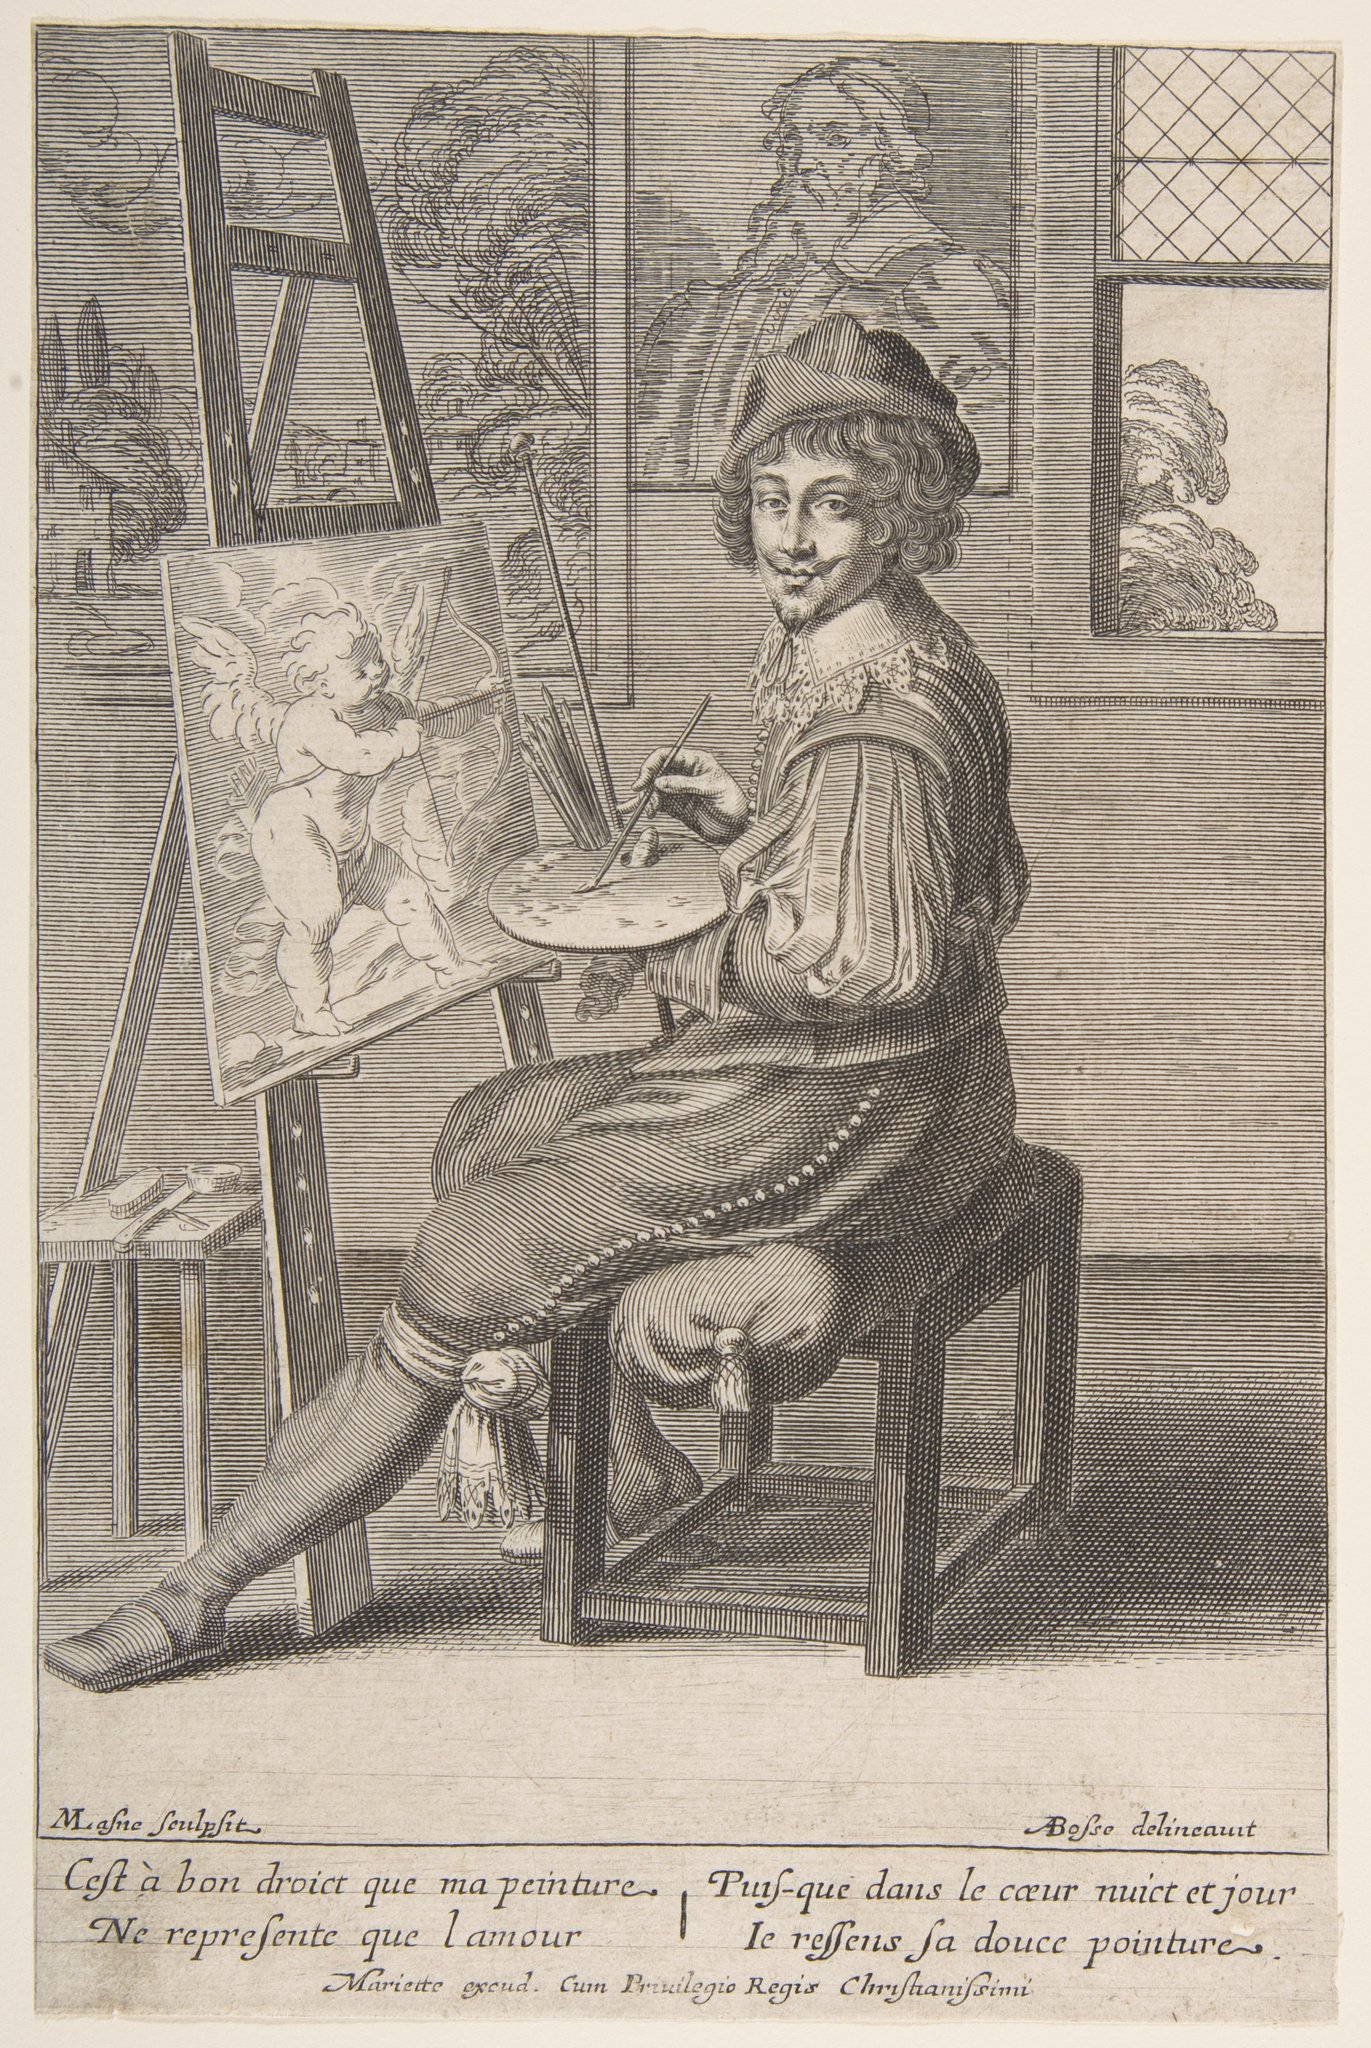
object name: print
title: Painter at an Easel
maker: michel lasne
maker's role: artist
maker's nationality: french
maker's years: 1590-1667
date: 1620-1667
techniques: engraving, etching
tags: painting,men,artists,easels,palettes